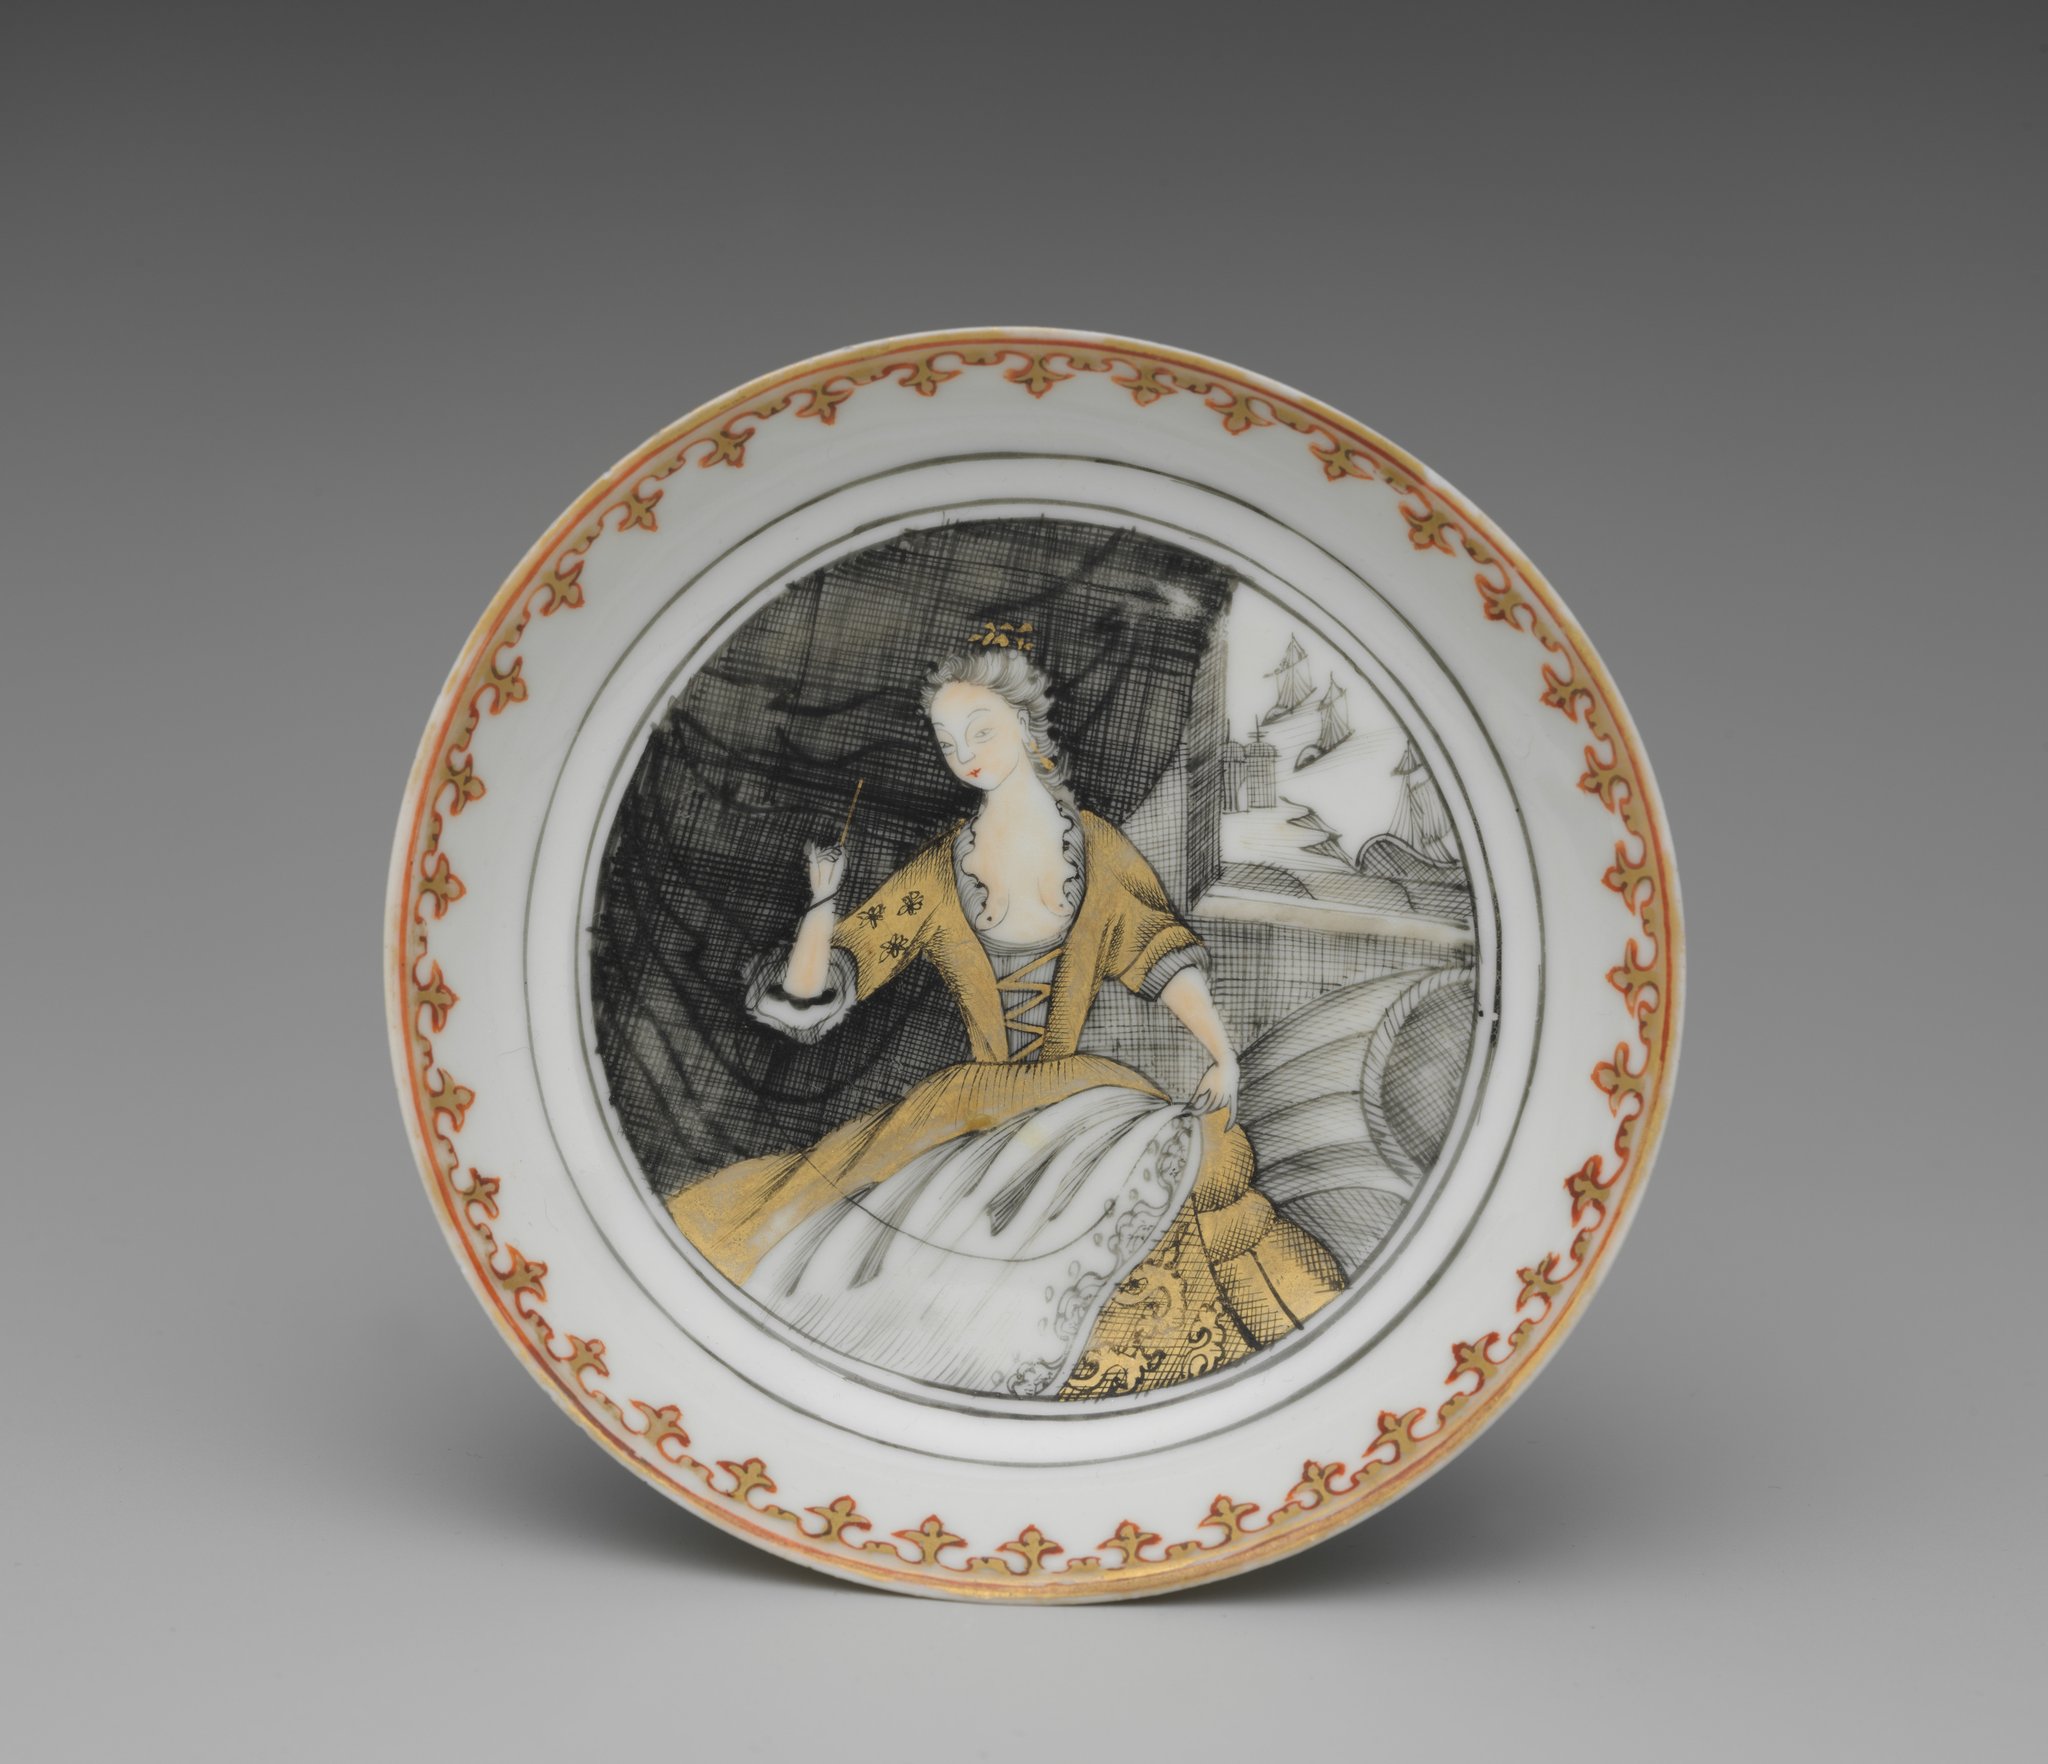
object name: saucer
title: Saucer (part of a service)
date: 1750-1770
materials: hard paste porcelain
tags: women,needlework,sewing